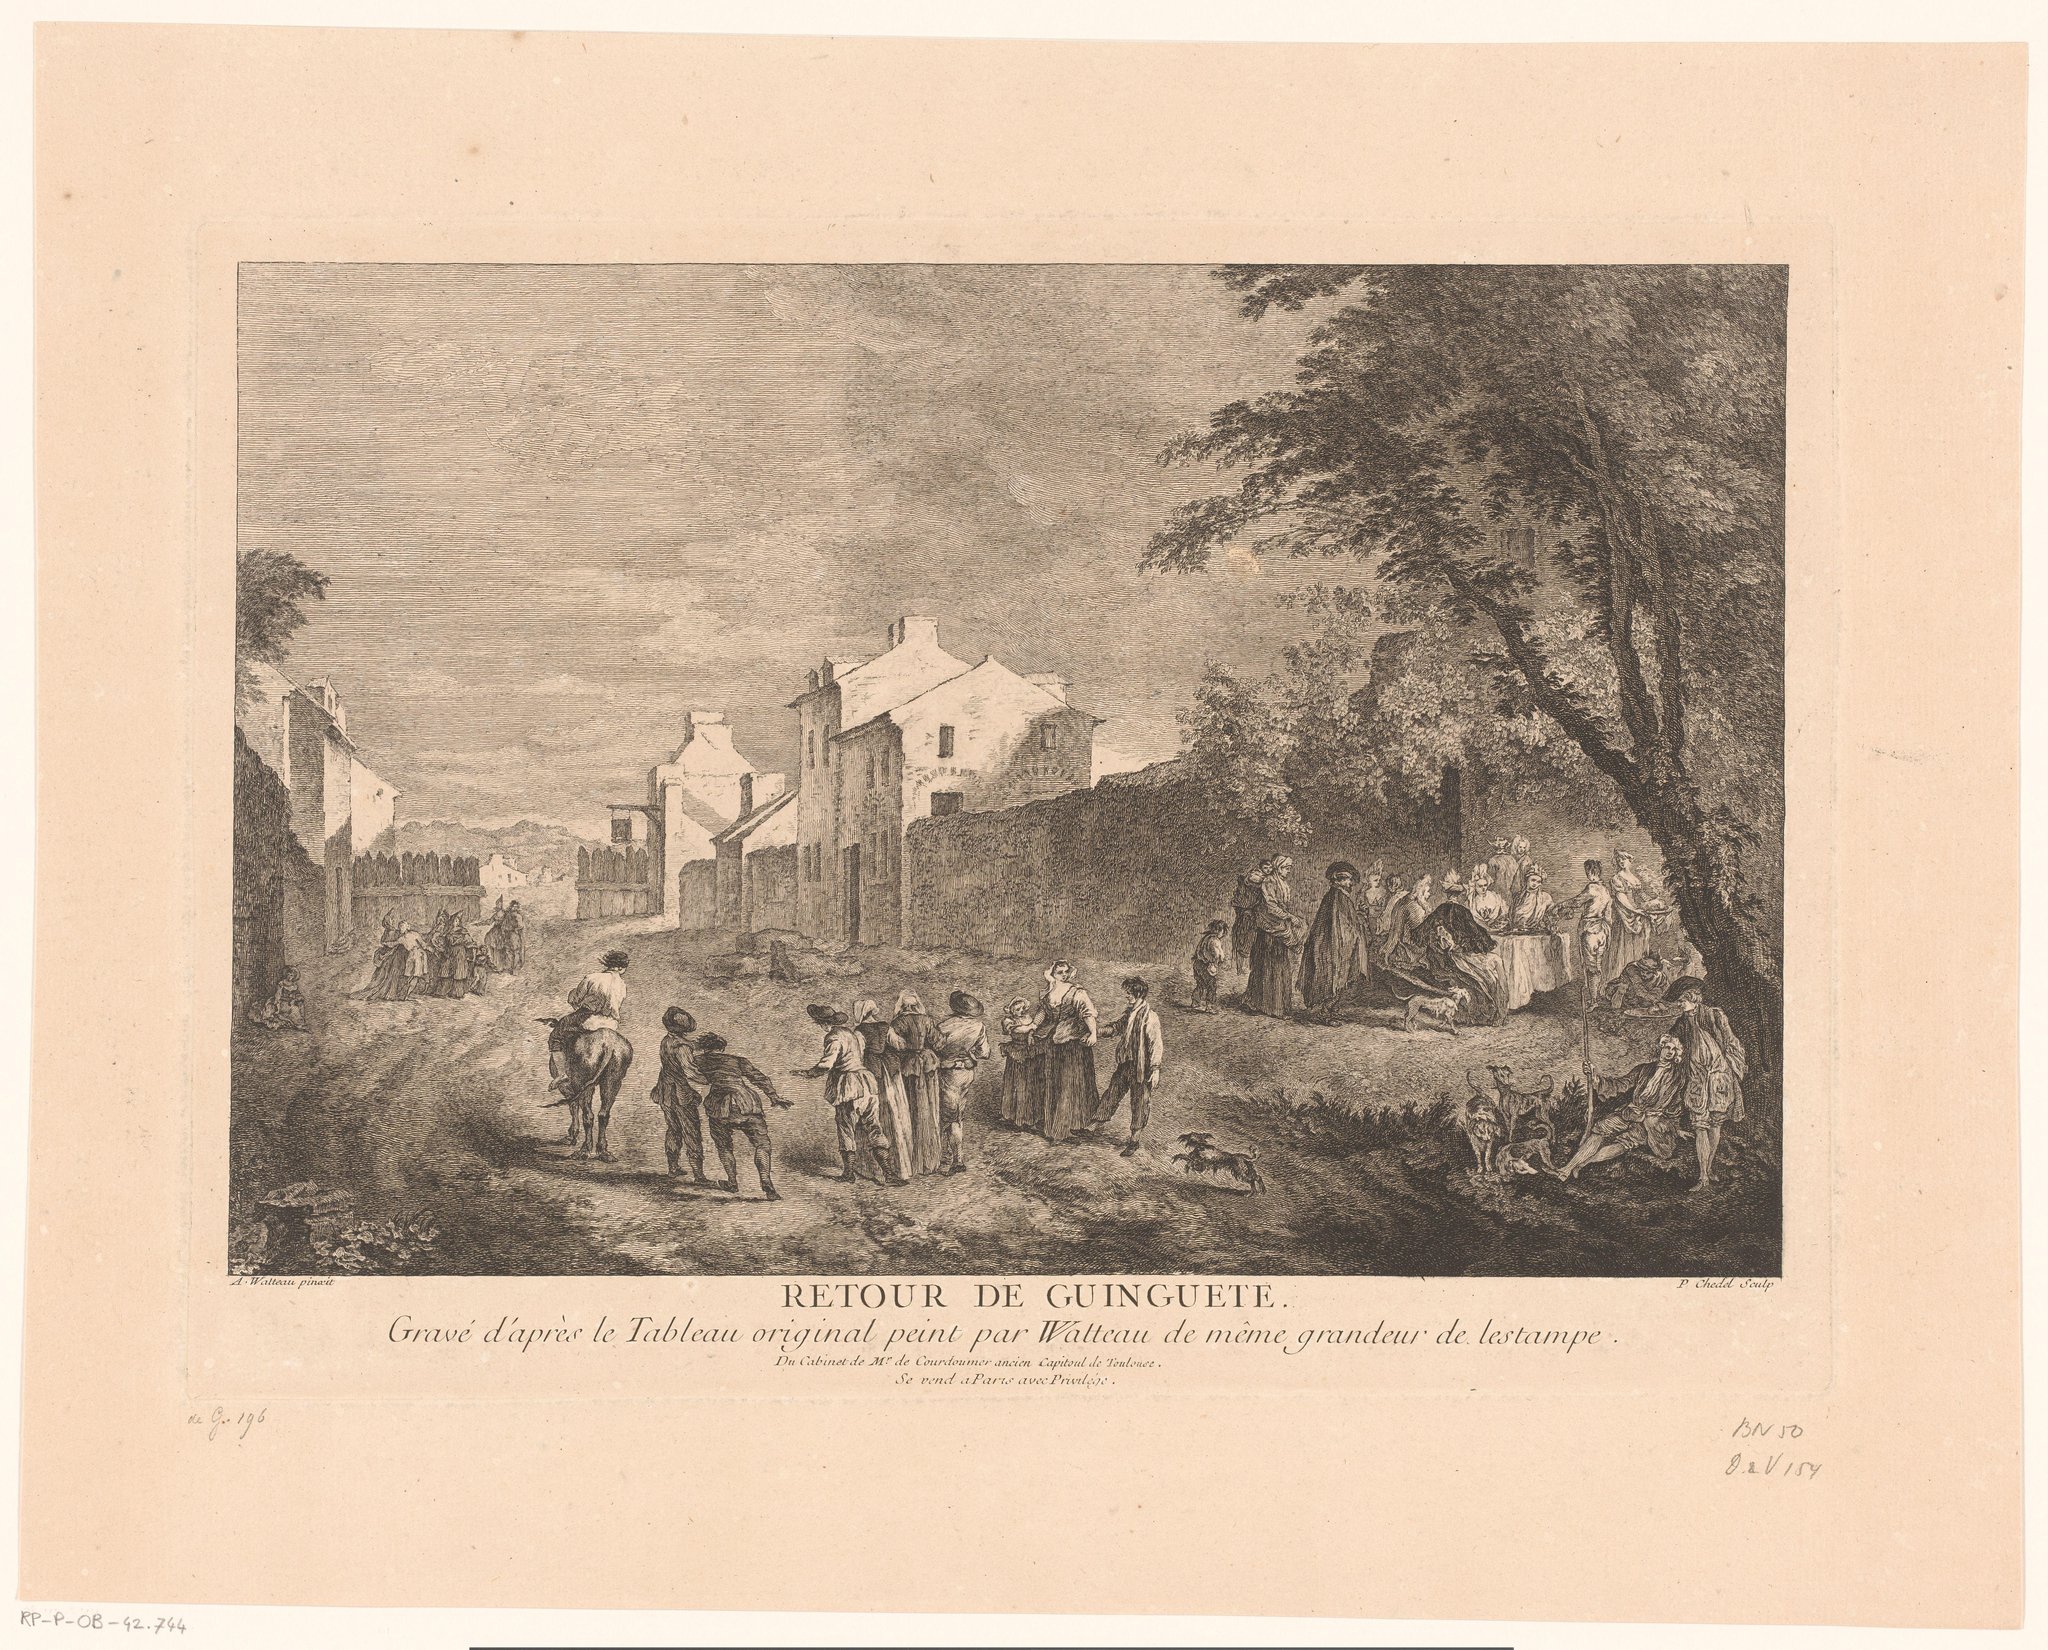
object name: print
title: Oeuvre van Antoine Watteau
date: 1715-1734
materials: paper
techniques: etching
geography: paris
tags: village, celebration meal, feast, banquet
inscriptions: collector's mark: Lugt 2228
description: Maakt deel uit van een serie van 271 platen, inclusief twee titelprenten, naar schilderijen door Watteau en verzameld door Jean de Jullienne. Sommige platen werden reeds tijdens Watteau's leven vervaardigd en de rest kwam pas na zijn dood tot stand. In 1734 werd het eind van de serie aangekondigd. Deze plaat betreft nr. 156 van de serie.